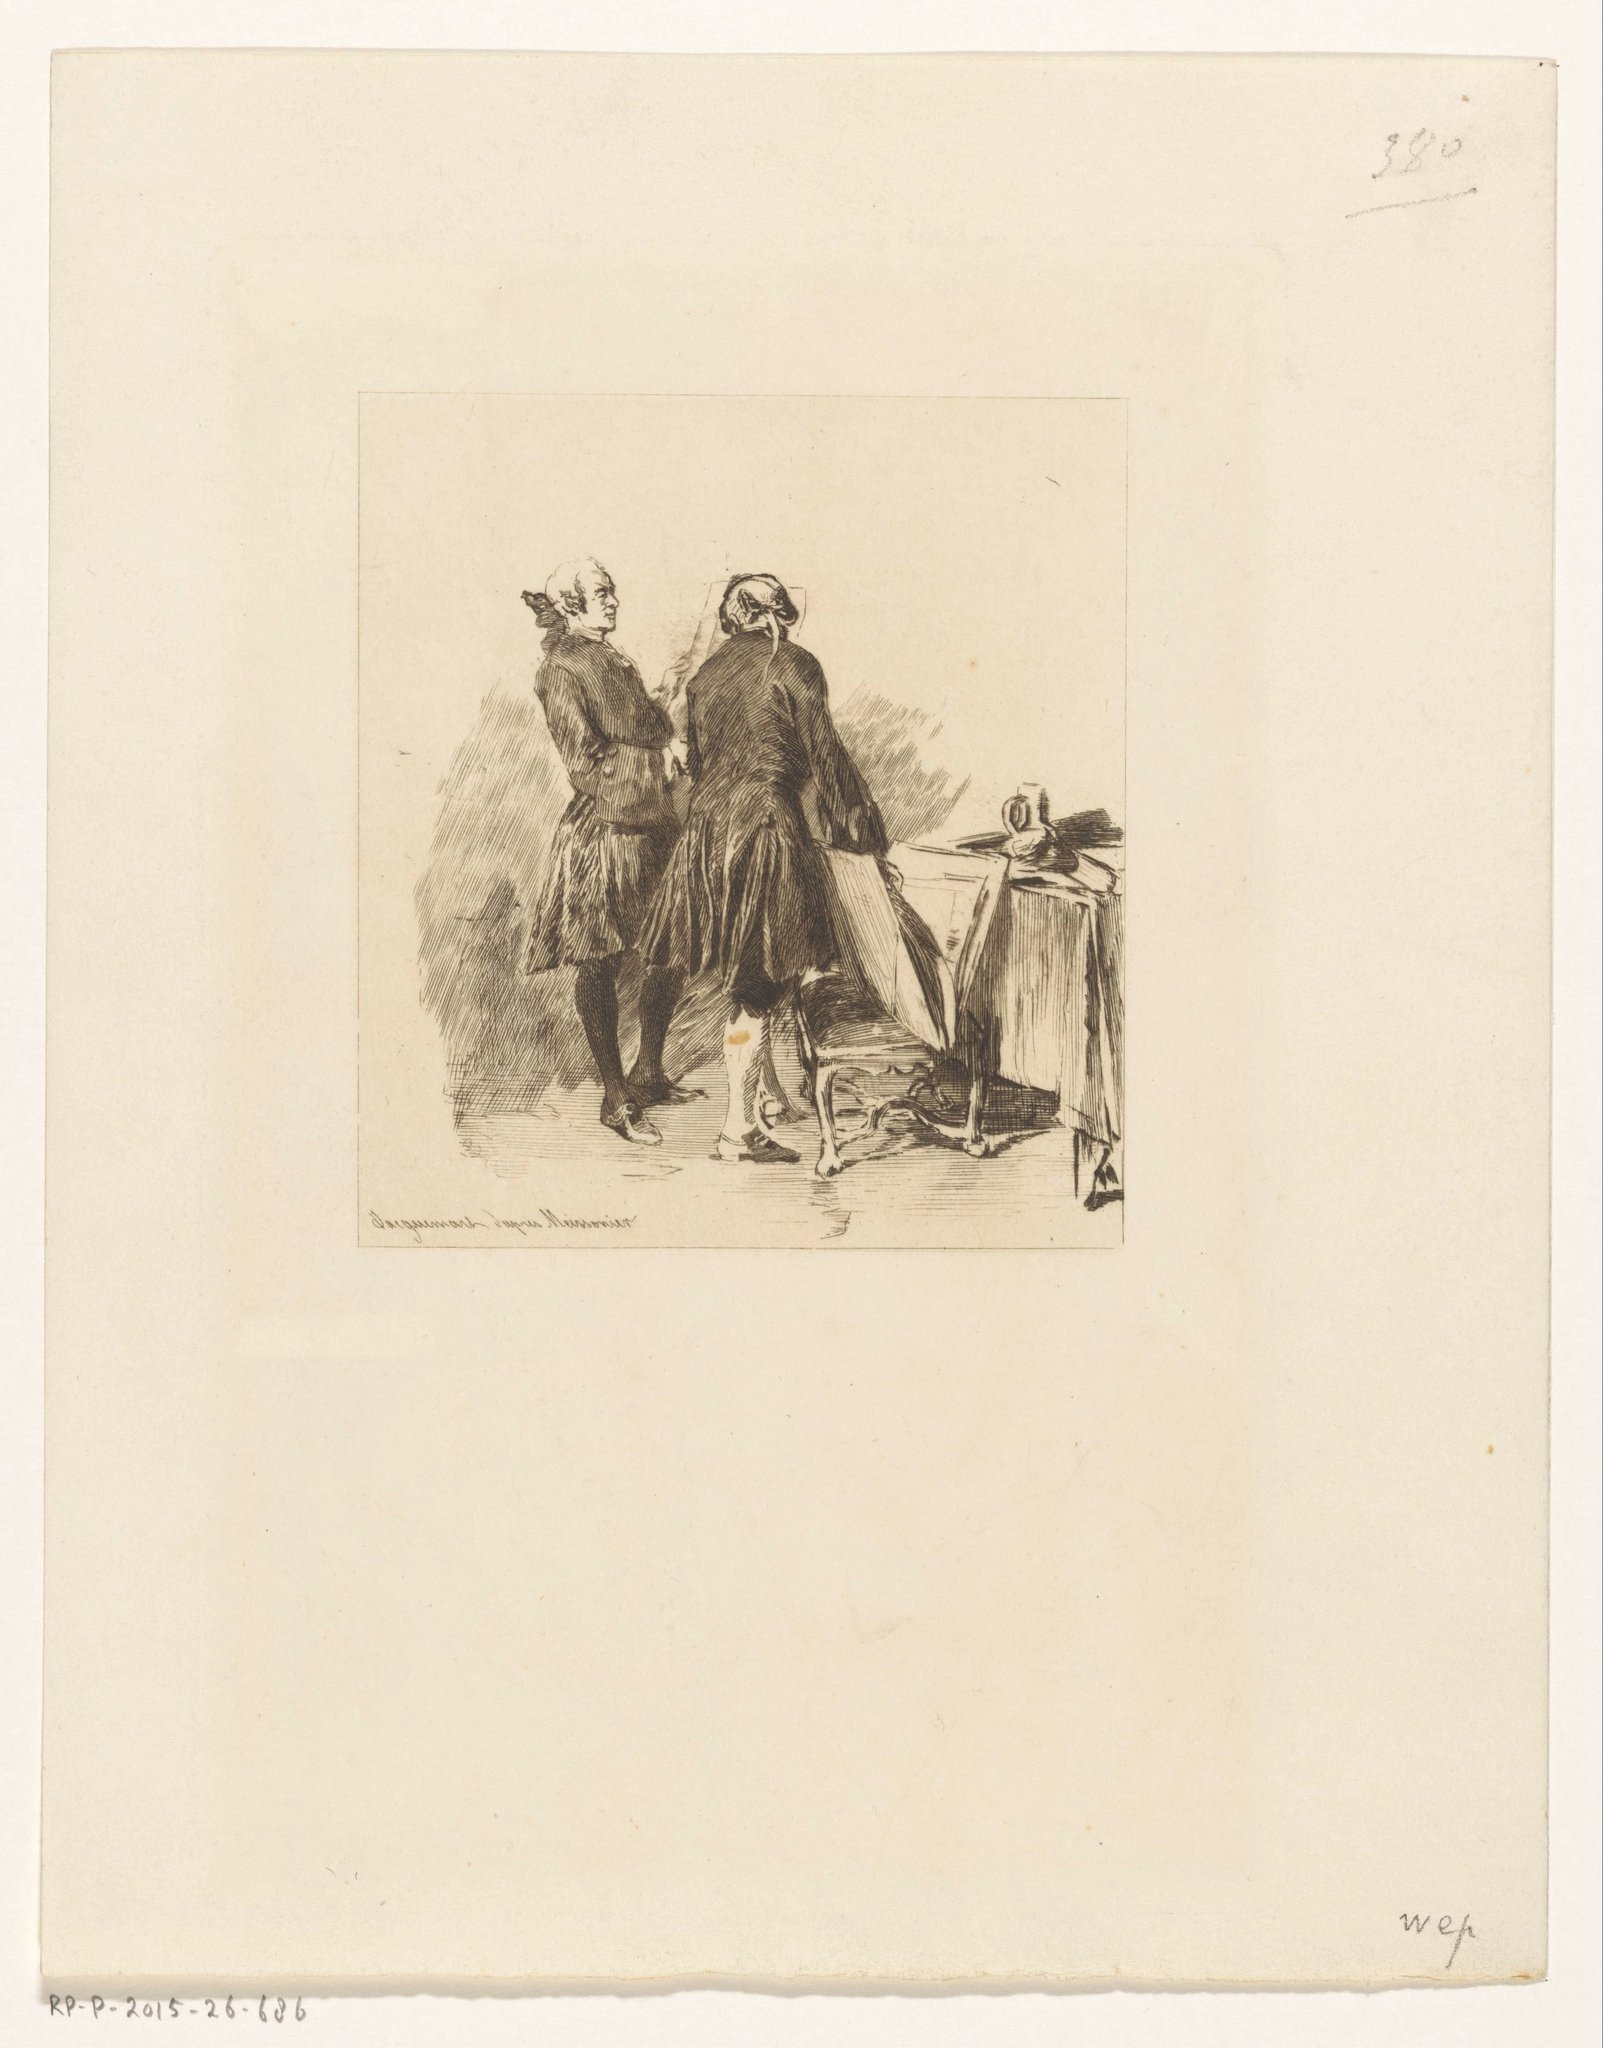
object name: print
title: Twee mannen in 18de-eeuwse kleding bekijken prenten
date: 1847-1880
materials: paper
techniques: drypoint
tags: print, e.g.: engraving, etching, lithograph, art collecting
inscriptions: collector's mark: Lugt 2228, collector's mark: Lugt 4780